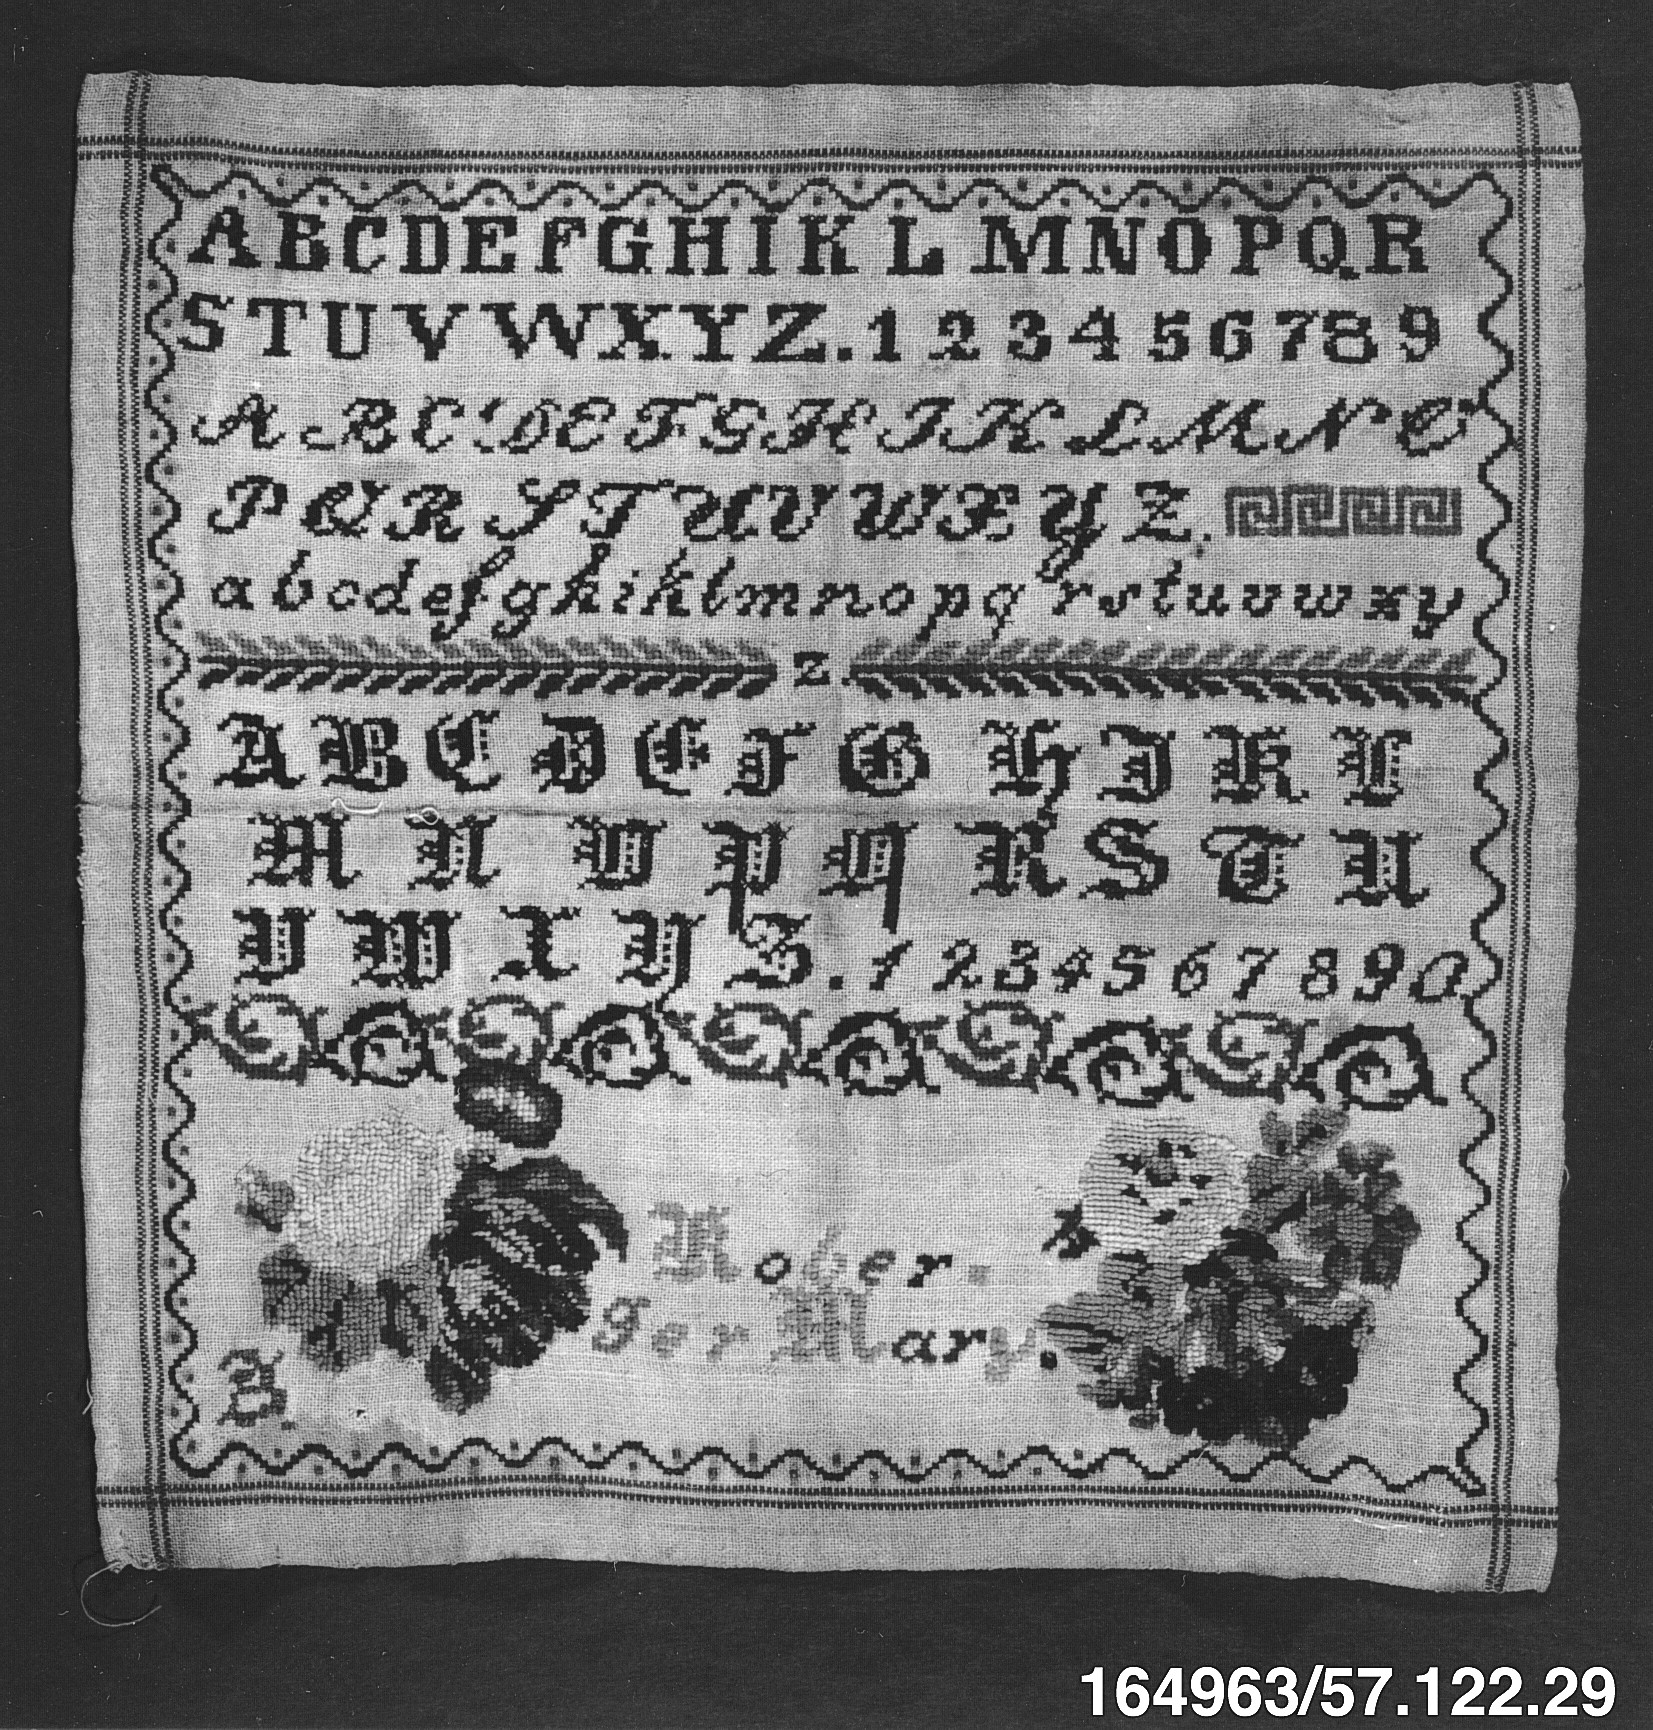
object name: sampler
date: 1801-1900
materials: cotton, wool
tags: flowers